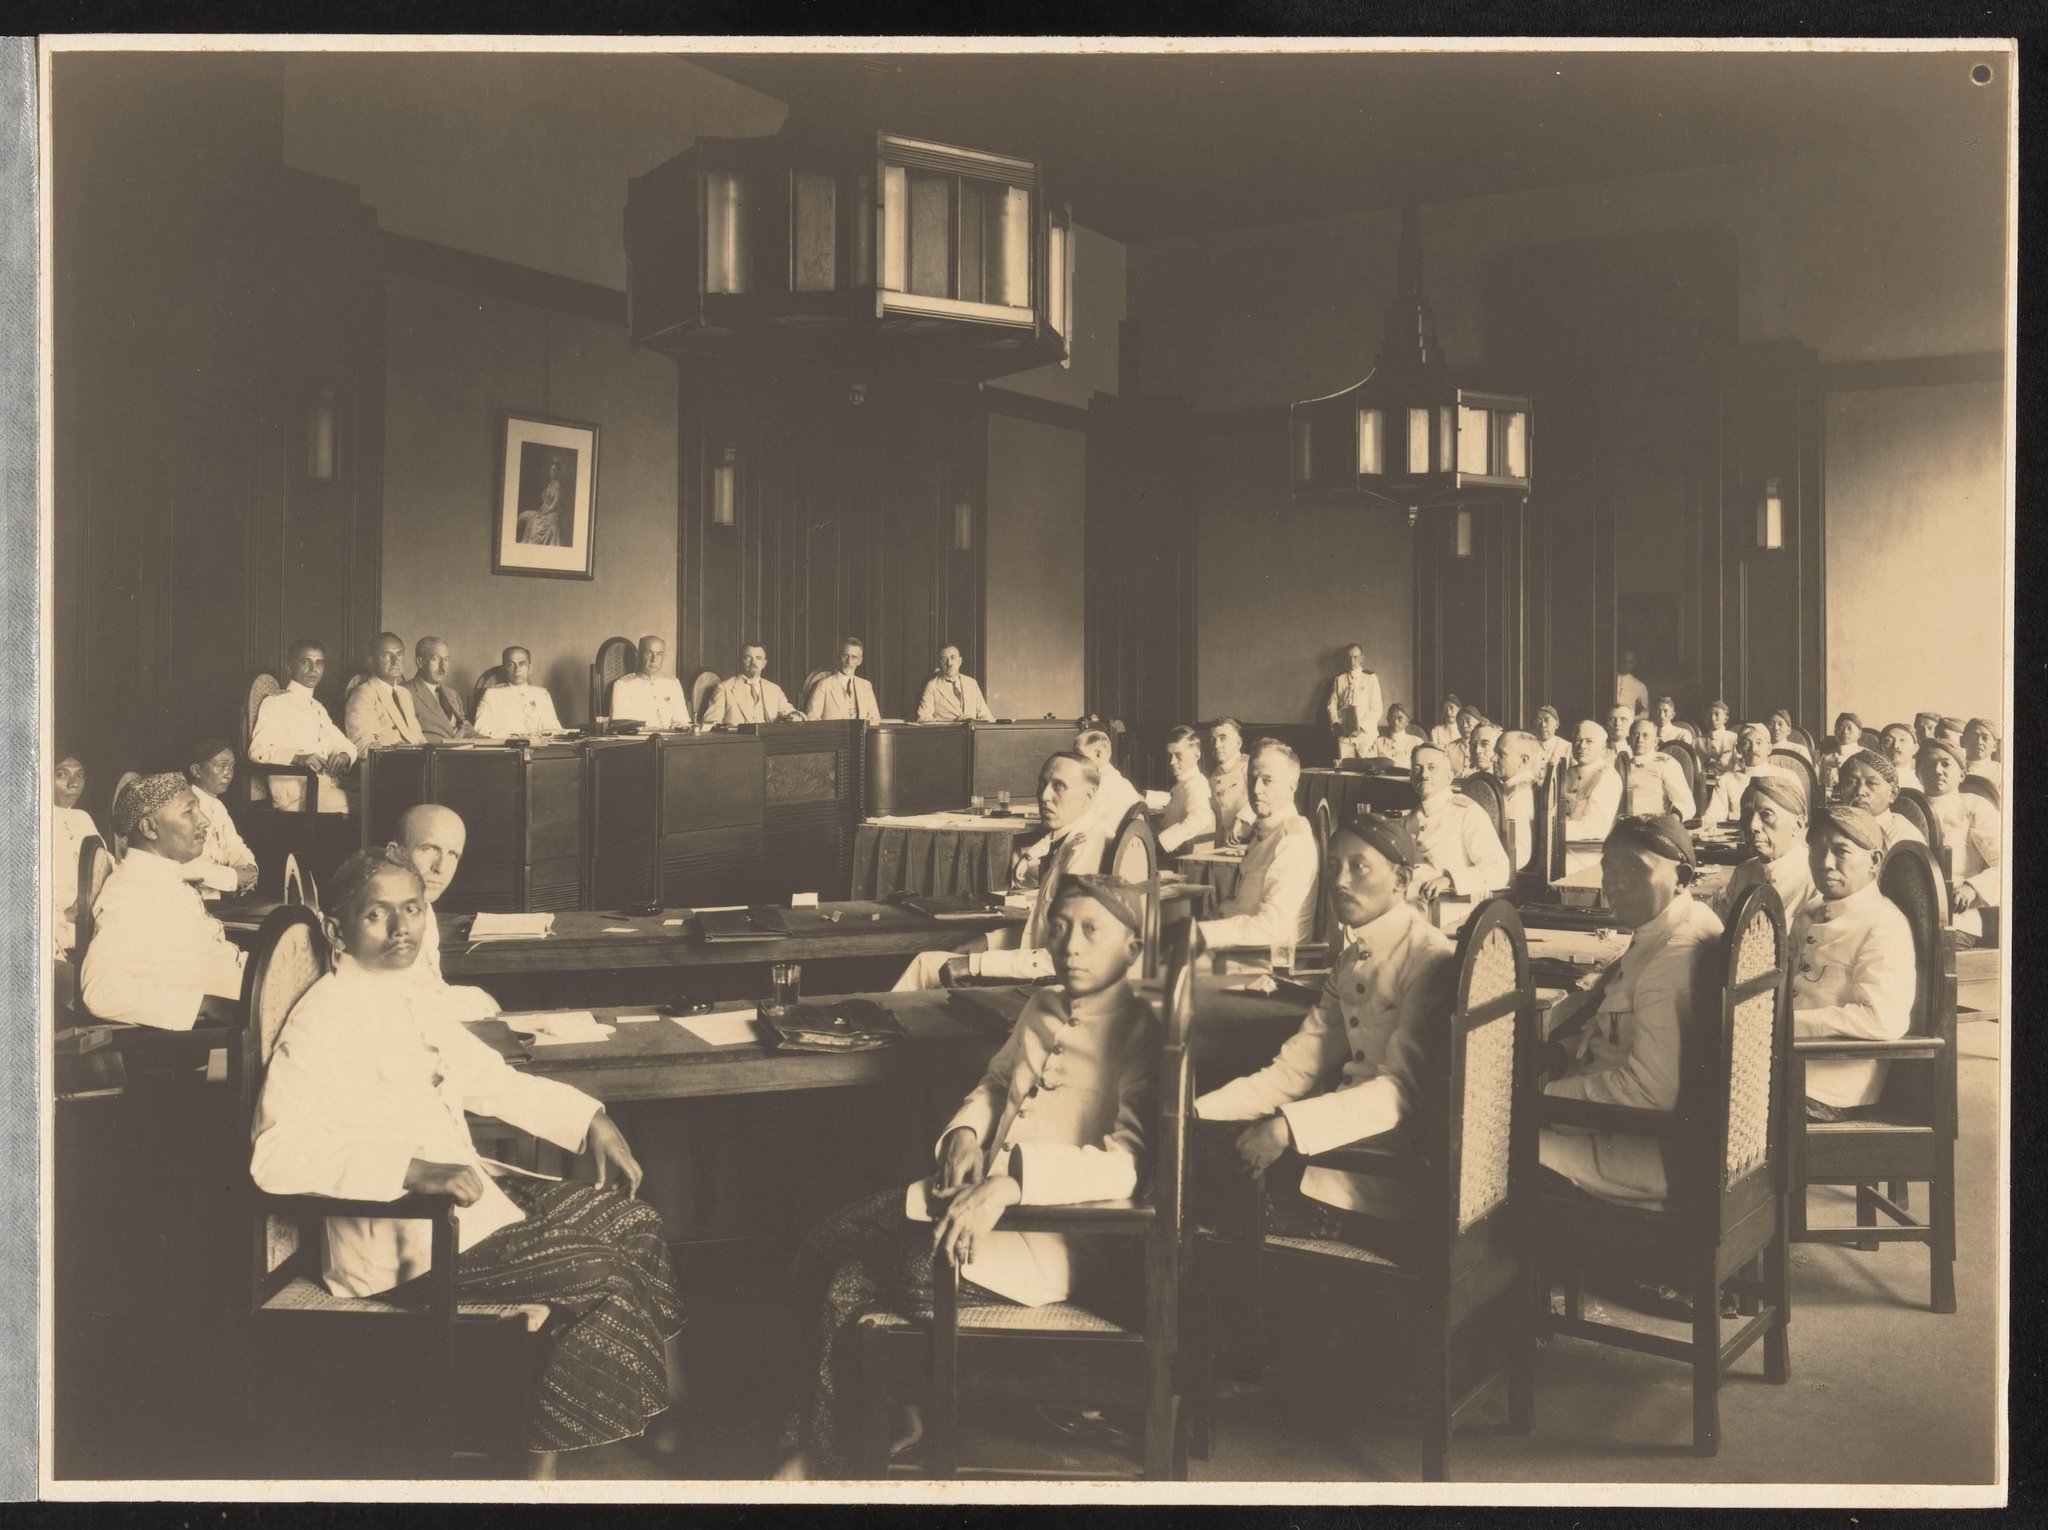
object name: photograph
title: Bijeenkomst van regenten van Midden-Java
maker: otto hisgen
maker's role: fotograaf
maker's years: 1874-1944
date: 1930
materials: photographic support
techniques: photography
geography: semarang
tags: the hague, leprosarium, colonial government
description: Bijeenkomst van de regenten van Midden-Java in Semarang in 1930 voorgezeten door gouverneur-generaaal A.C.D. de Graeff, aan zijn rechterhand de gouverneur van Midden-Java A.H. Neijs. Losse foto in de map met herinneringsfoto's van het bezoek aan de Semarang-leprozerie te Pelantoengan in mei 1931 aangeboden aan gouverneur A.H. Neijs.